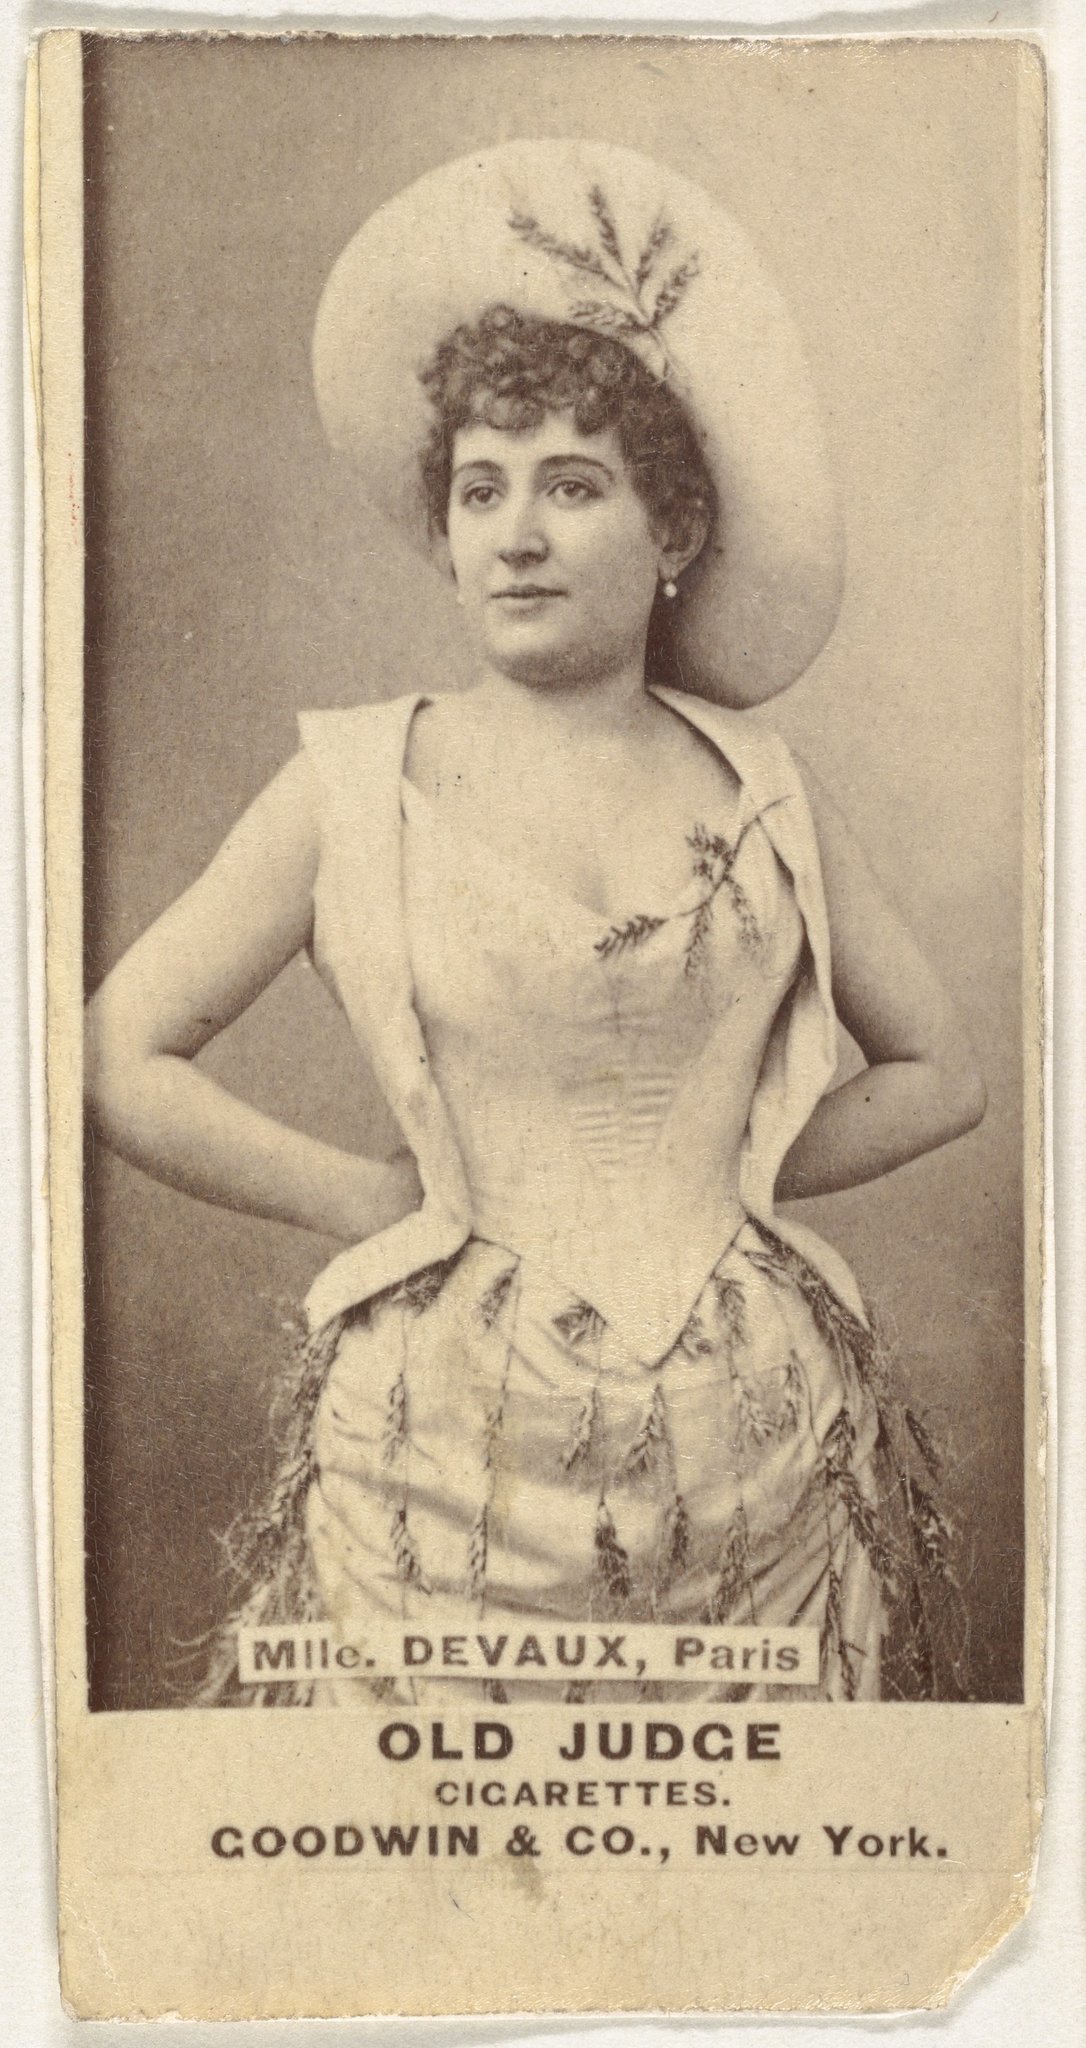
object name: photograph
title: Mlle. Devaux, Paris, from the Actors and Actresses series (N171) for Old Judge Cigarettes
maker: goodwin & company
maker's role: publisher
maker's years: 1850-1950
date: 1886-1890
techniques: albumen silver print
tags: portraits,women,actresses